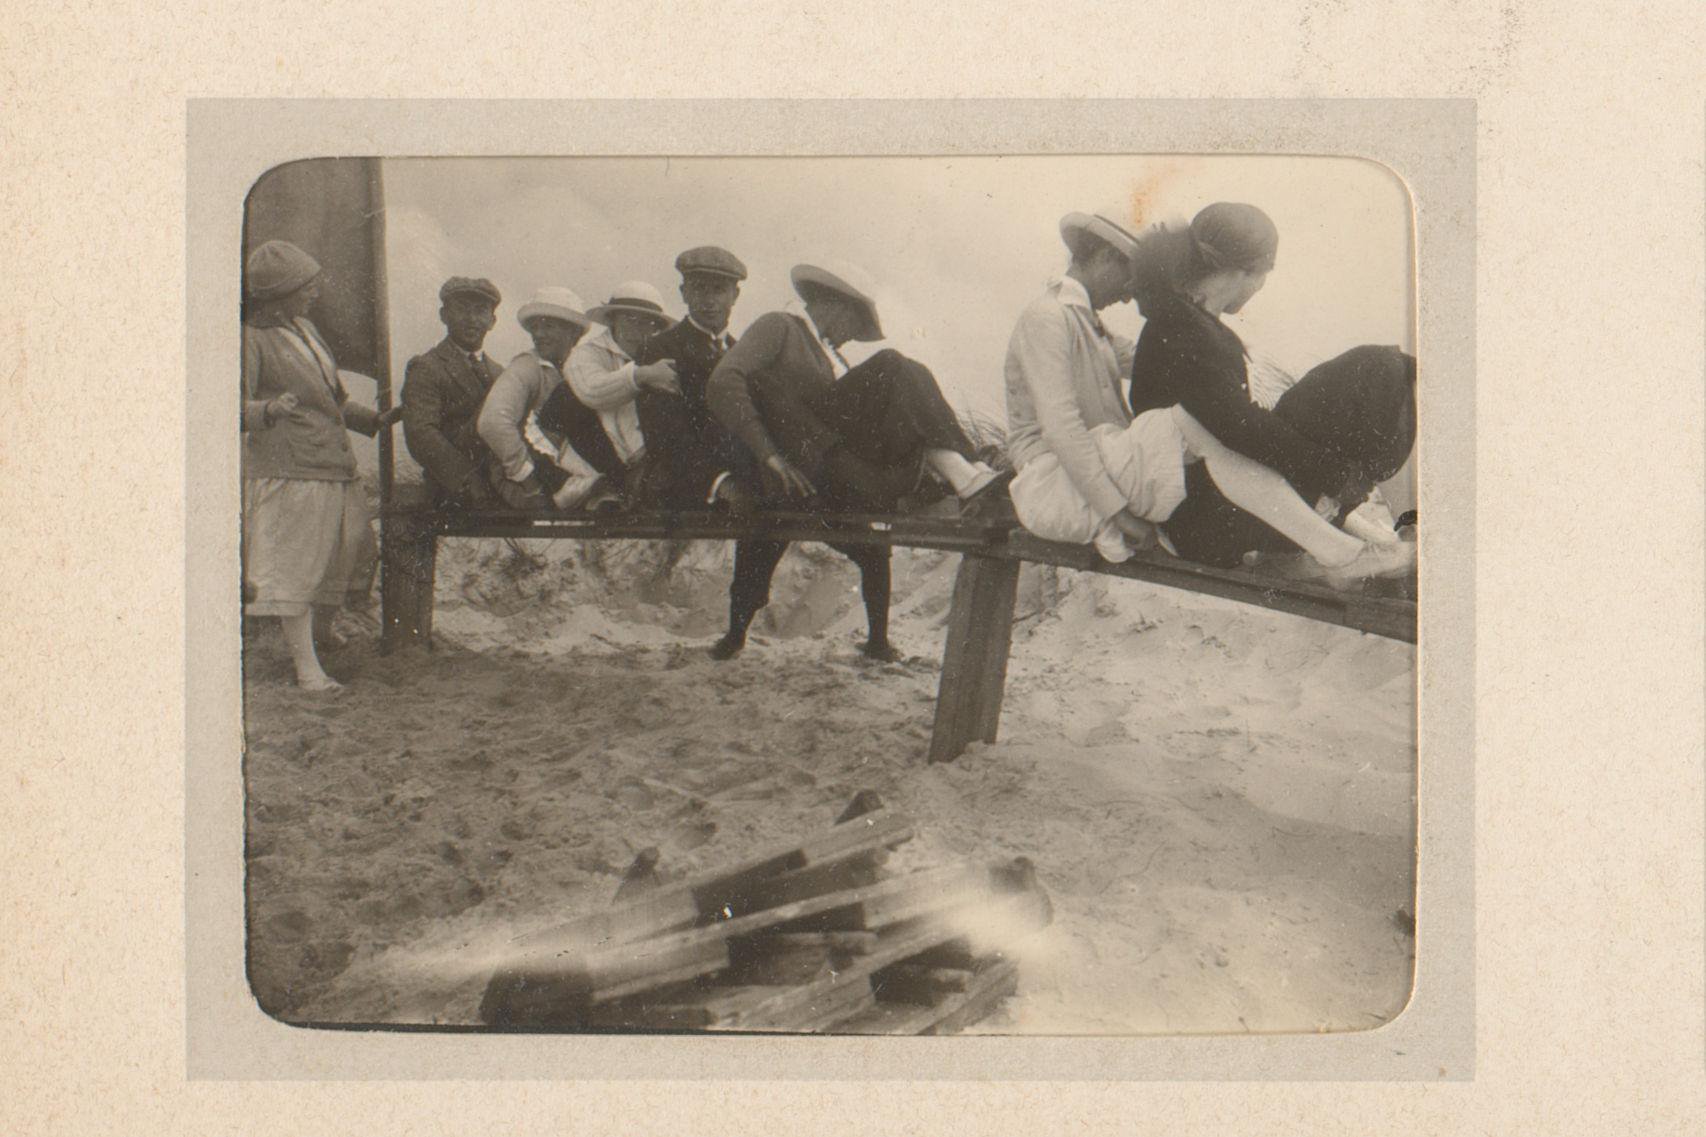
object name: album leaf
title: Gezelschap zittend op een houten omheining, waarschijnlijk in de duinen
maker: liesbeth overhoff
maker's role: fotograaf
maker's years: 1895-1969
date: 1915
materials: paper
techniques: gelatin silver print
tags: fence, wall, paling, historical persons, dunes (sea not visible); in the dunes